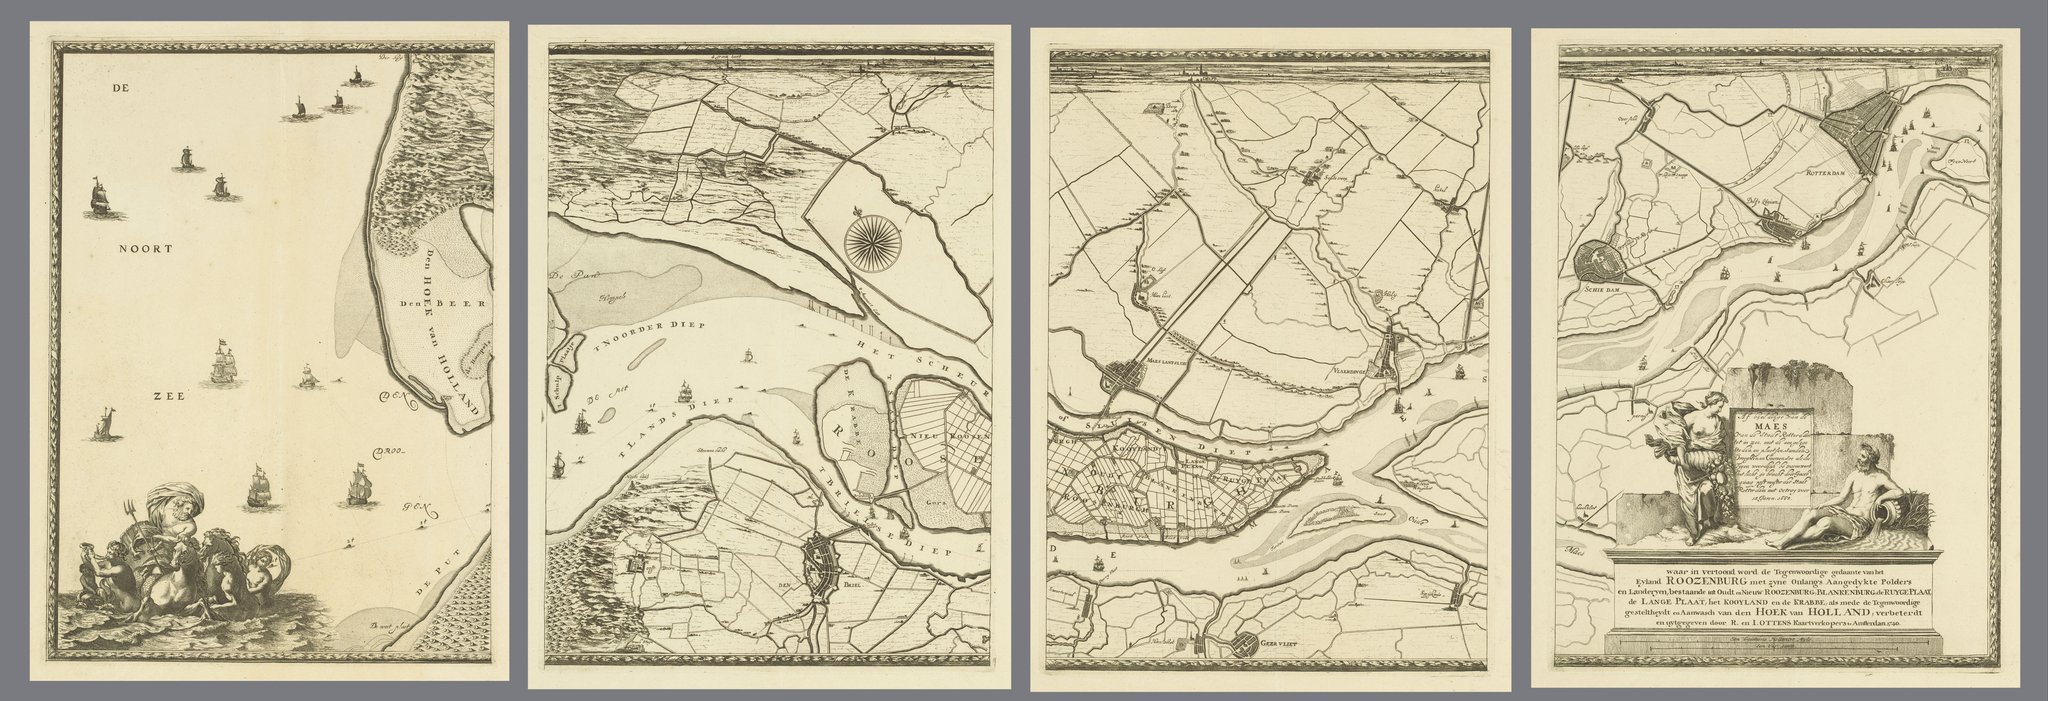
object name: map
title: Kaart van de Maas van Rotterdam tot de Noordzee, bestaande uit vier delen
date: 1666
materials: paper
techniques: engraving, etching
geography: amsterdam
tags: 'cornucopia', horn of plenty, triton(s), maps of separate countries or regions, river-gods, maps of cities, neptune as lord of the sea, delfshaven, geervliet, rotterdam, brielle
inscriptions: collector's mark: Lugt 2228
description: Dit object is omwille van een betere presentatie virtueel samengevoegd maar bestaat fysiek uit losse onderdelen. De eerste staat van deze prent is oorspronkelijk bedoeld als onderdeel van de zogenaamde Maaskaart uit 1666, verschenen onder de titel 'Rotterodamum Hollandiae urbs celeberrima et situ portibusque mercaturae opportunissima. Ao. 1665'. Hoewel het jaartal 1665 in de titel stond, blijkt uit archiefonderzoek dat de kaart pas in 1666 gereed was (zie documentatie). Zie ook RP-P-AO-13-5 voor meer informatie.